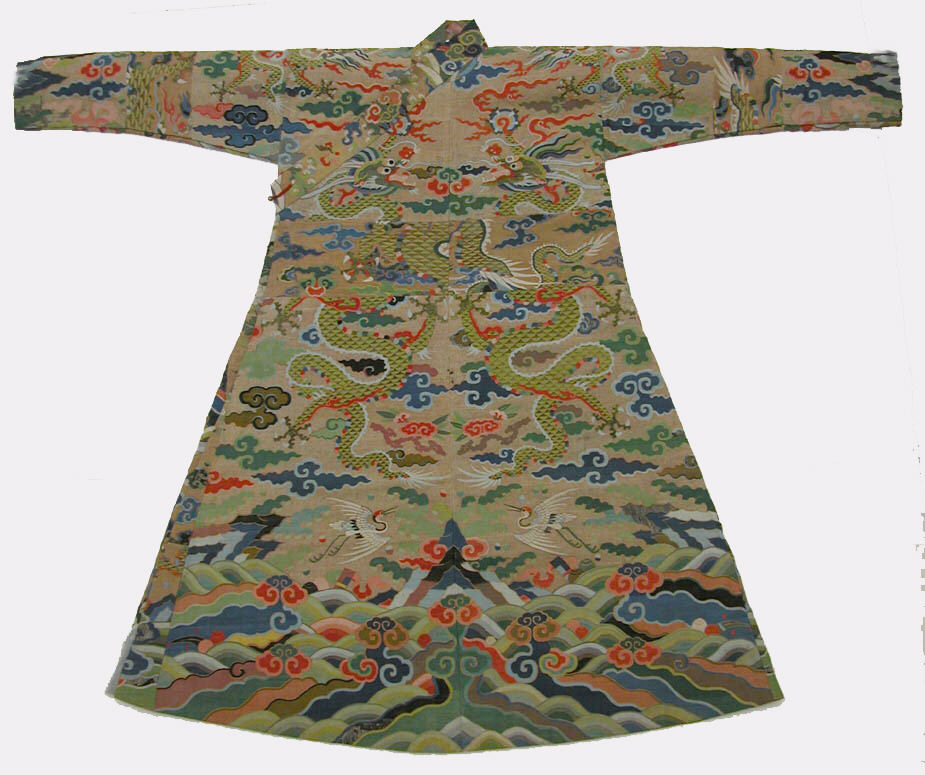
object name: robe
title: Robe for Tibetan aristocrat (chuba)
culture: tibetan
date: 1701-1800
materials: feather, gold, silk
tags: cranes,dragons